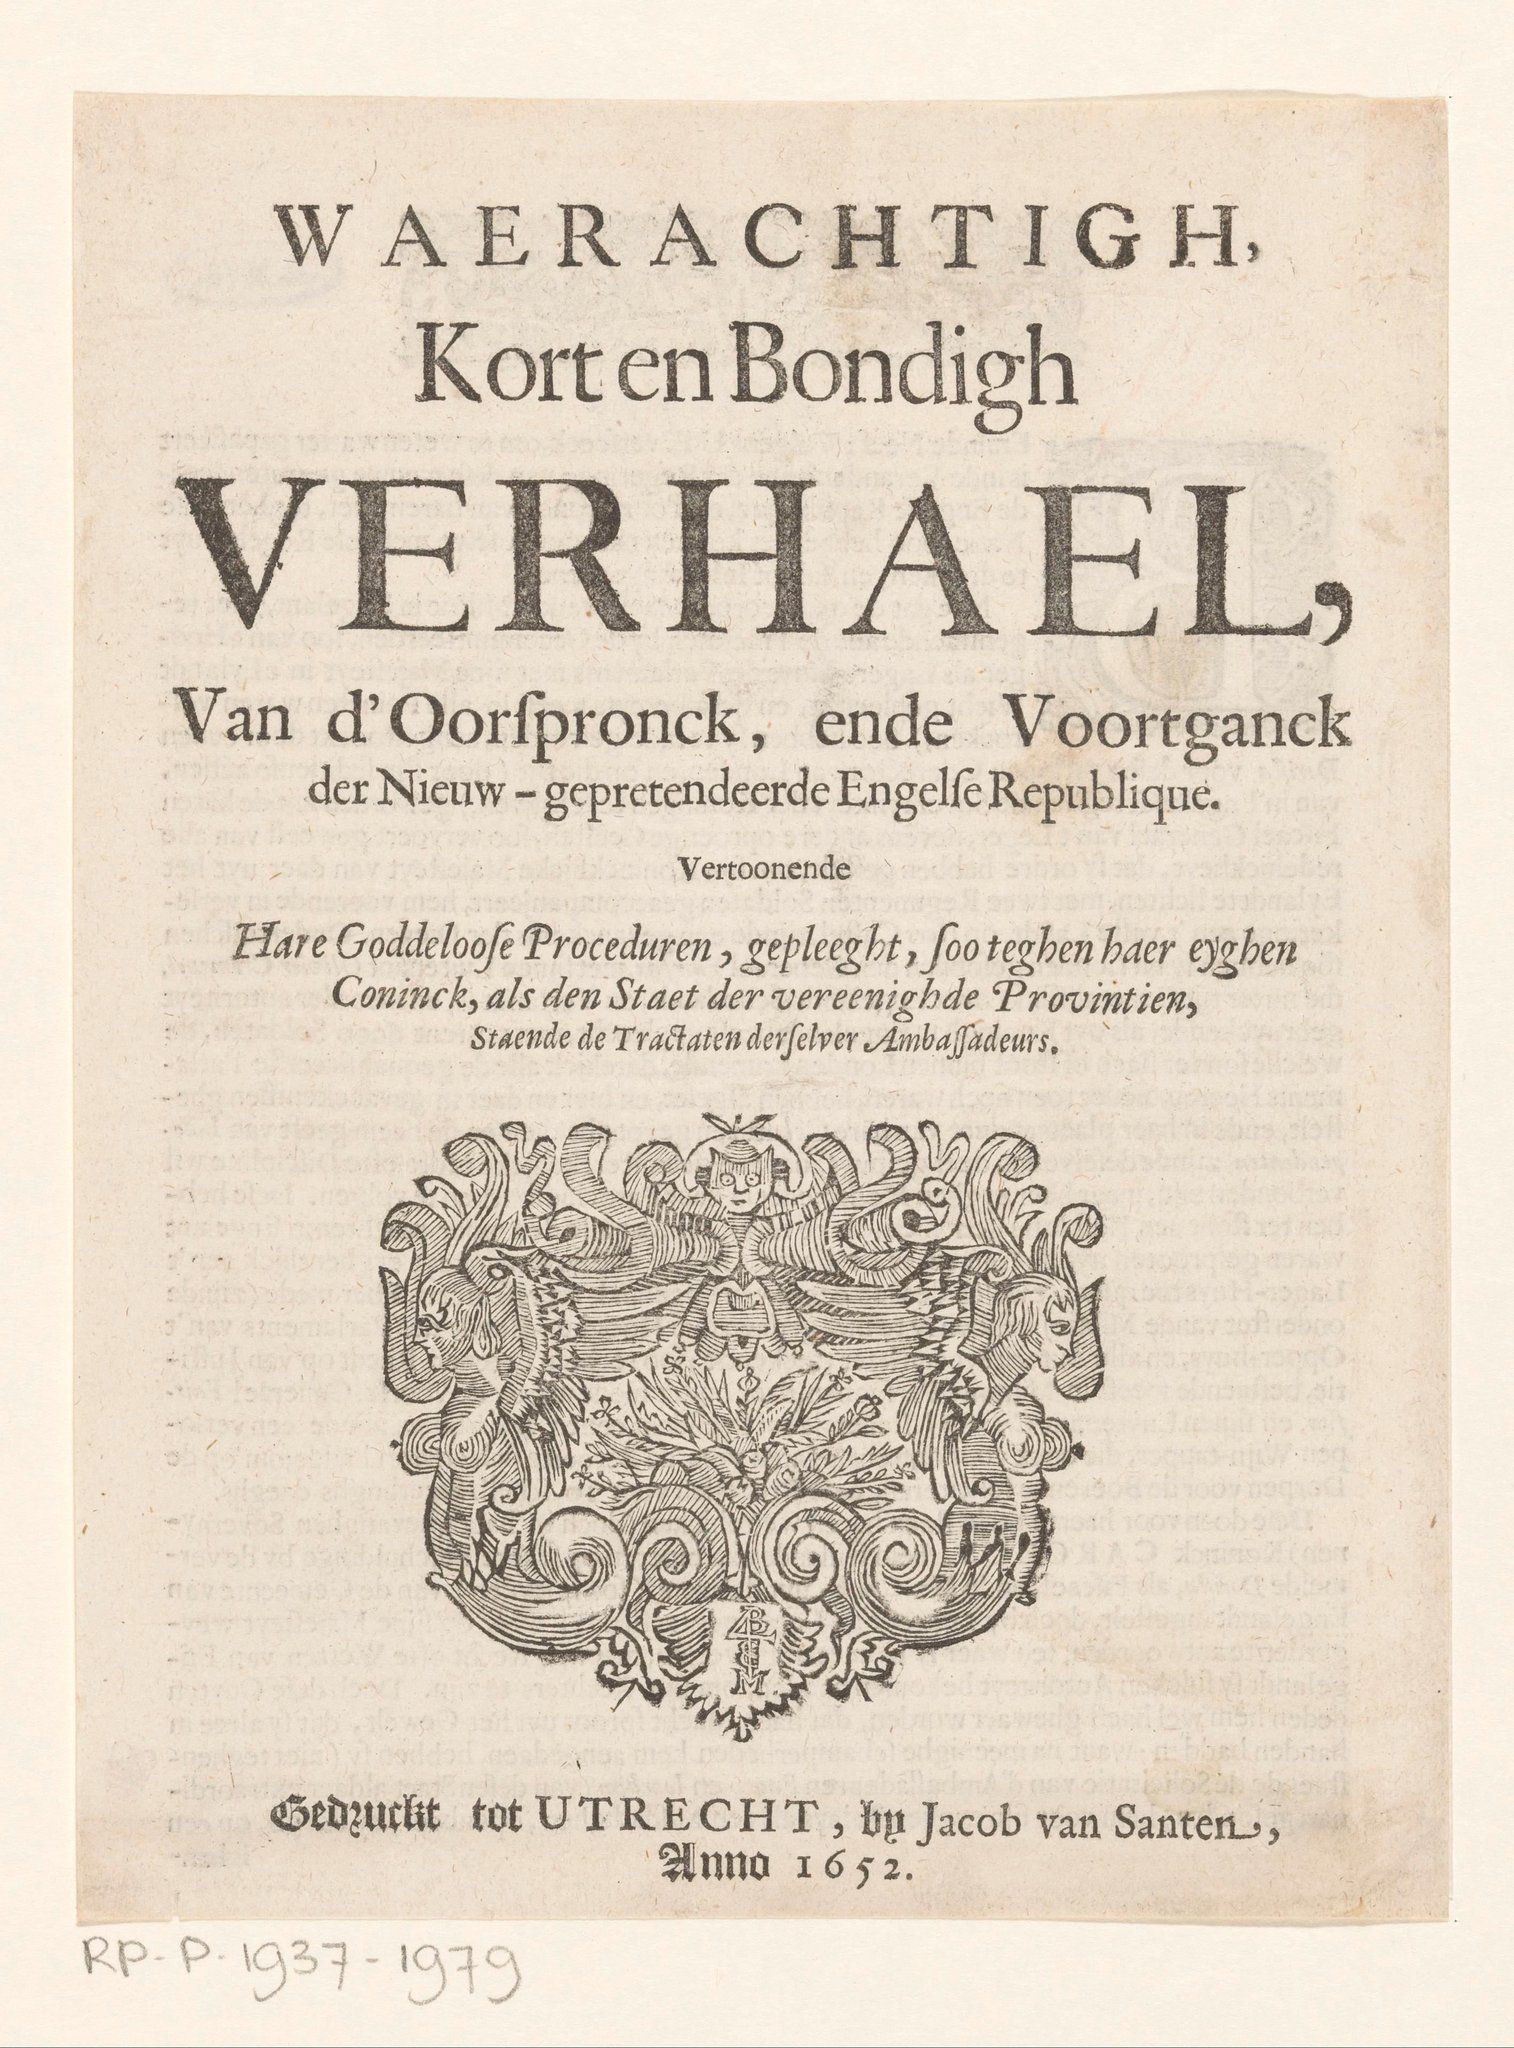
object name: titelblad, titelpagina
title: Ornament met engelen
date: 1652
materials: paper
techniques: letterpress printing, engraving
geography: utrecht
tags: ornaments ~ art, angels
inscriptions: collector's mark: Lugt 2228, collector's mark: Lugt 2760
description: Ornament met twee engelen, een masker en plantmotieven. Verso gedrukte tekst met groot initiaal en een ornament met saters.